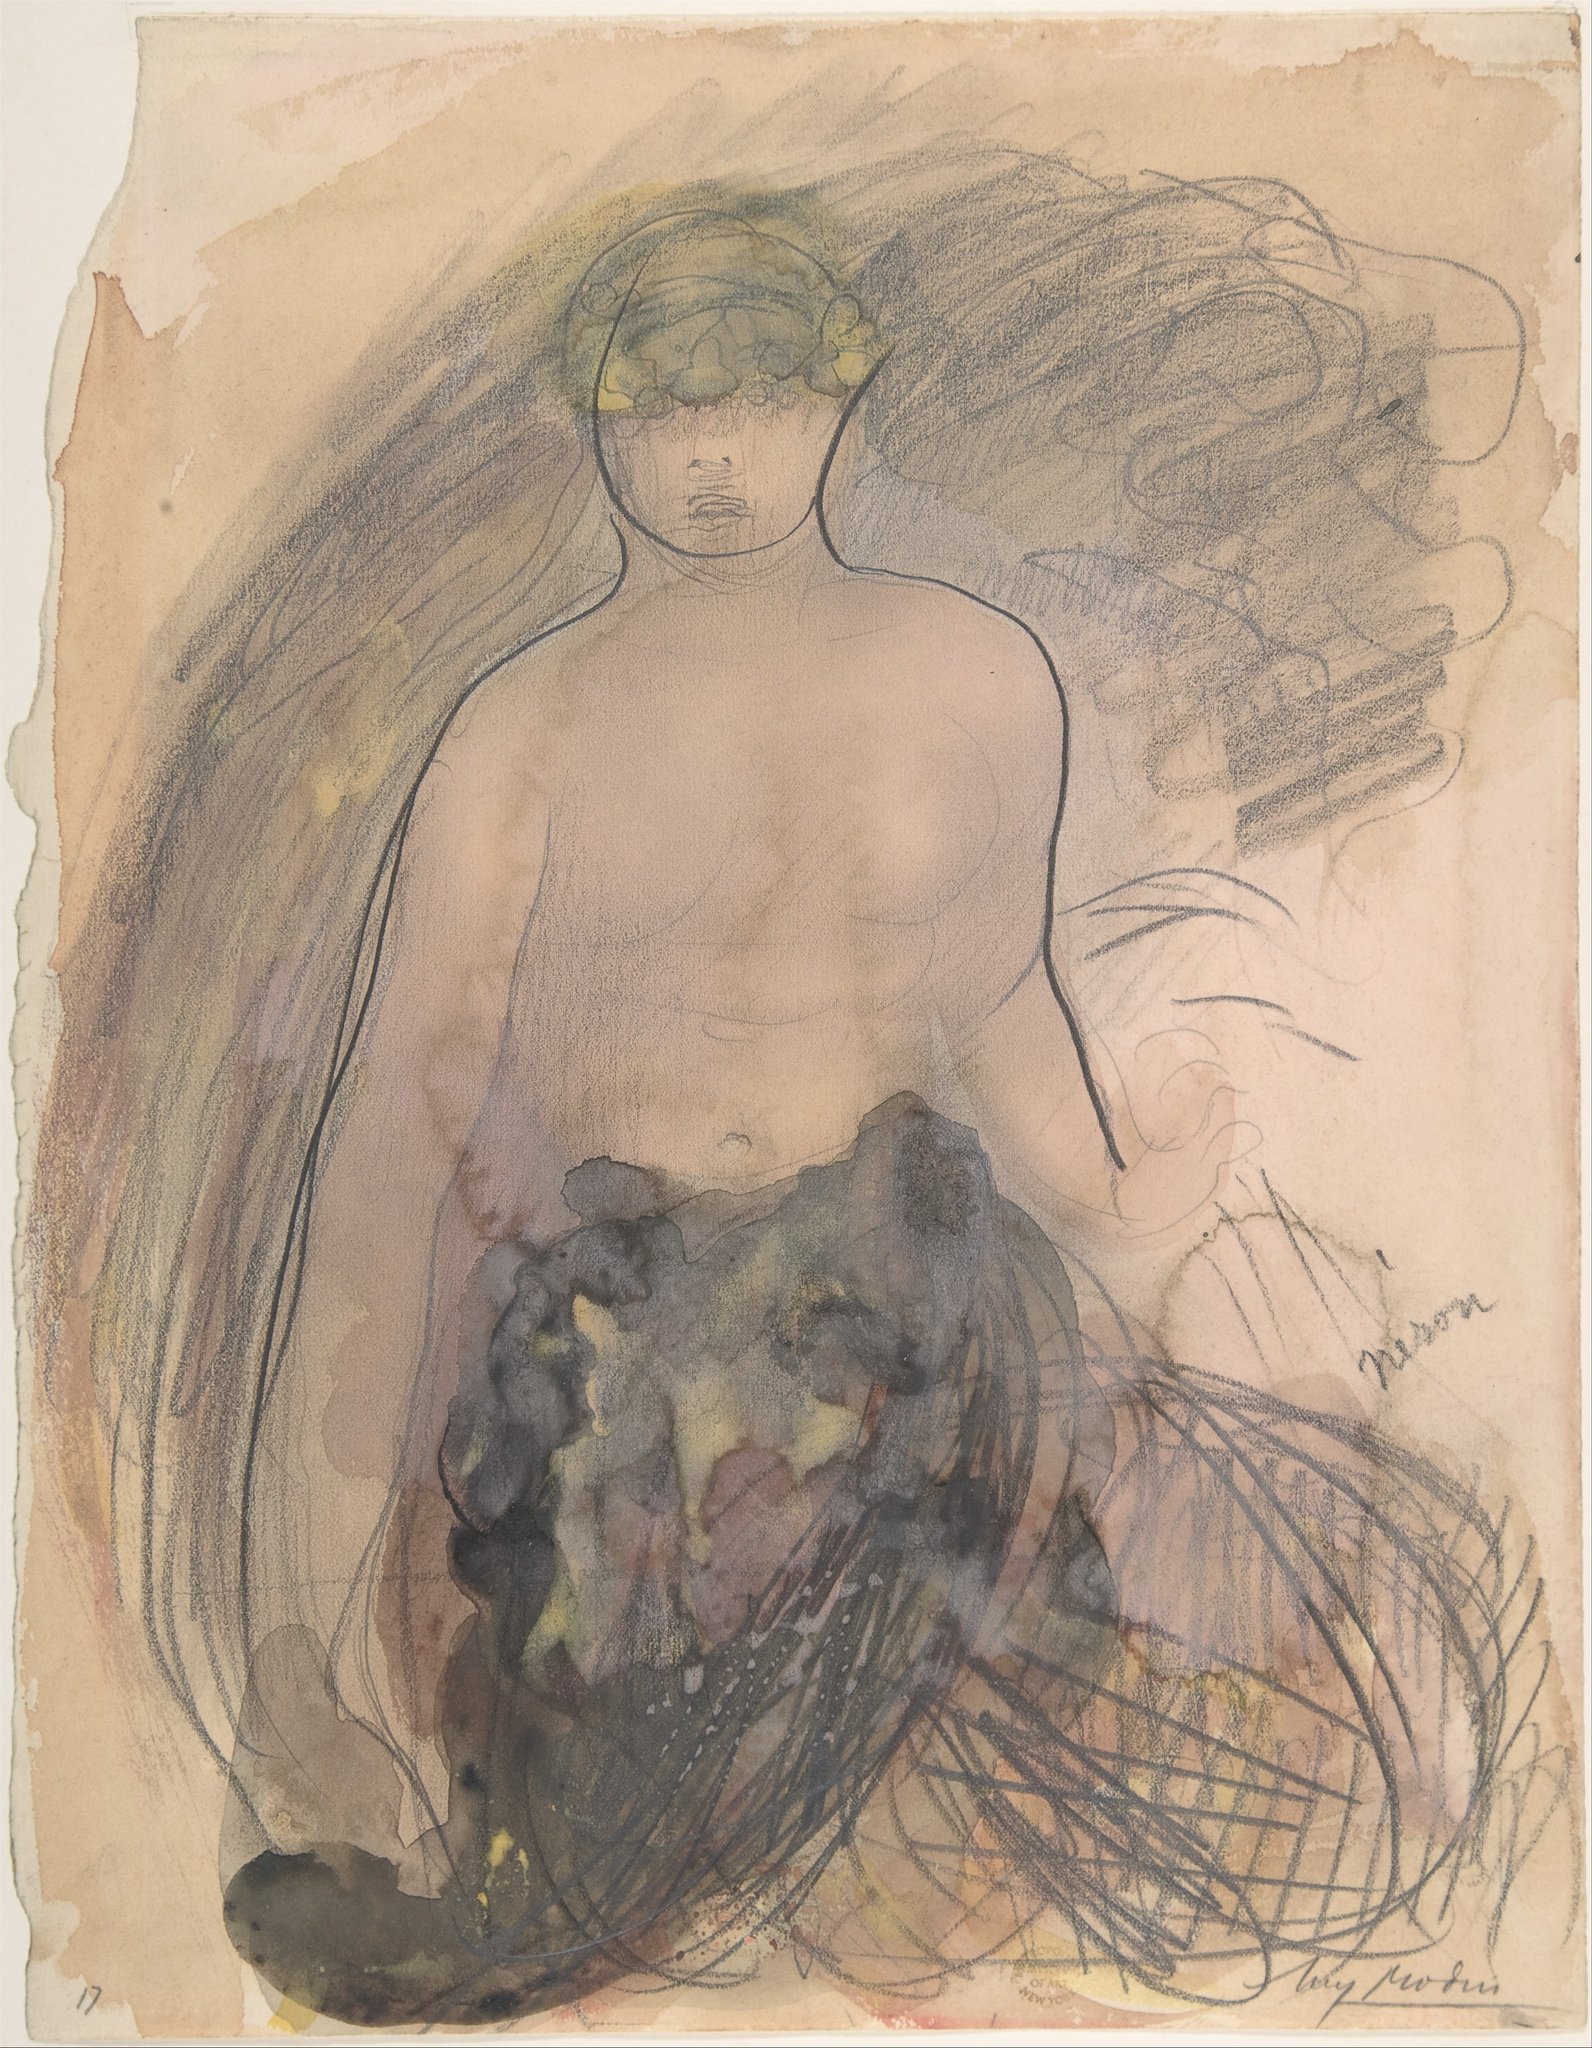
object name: drawing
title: Nero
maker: auguste rodin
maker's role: artist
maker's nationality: french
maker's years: 1840-1917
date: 1900-1910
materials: gouache, graphite, watercolor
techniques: stumping